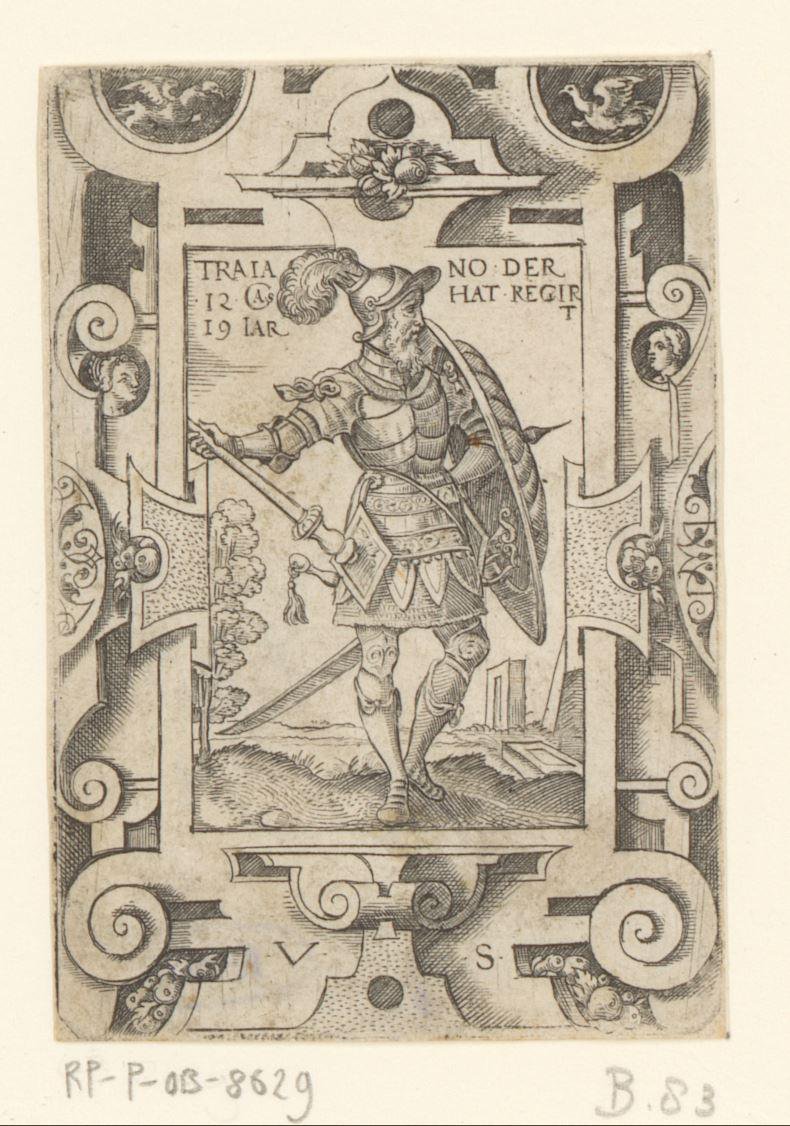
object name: print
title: Trajanus in rolwerk omlijsting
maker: virgilius solis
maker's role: draughtsman, print maker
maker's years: 1514-1562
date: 1524-1562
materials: paper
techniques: engraving, etching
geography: nuremberg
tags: (story of) the emperor trajan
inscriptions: collector's mark: Lugt 2228, number: ‘125’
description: Deze prent maakt deel uit van een serie bestaande uit twaalf prenten met de eerste Romeinse keizers staand in rolwerk omlijstingen. In de collectie van het Rijksmuseum bevinden zich elf van de twaalf prenten.